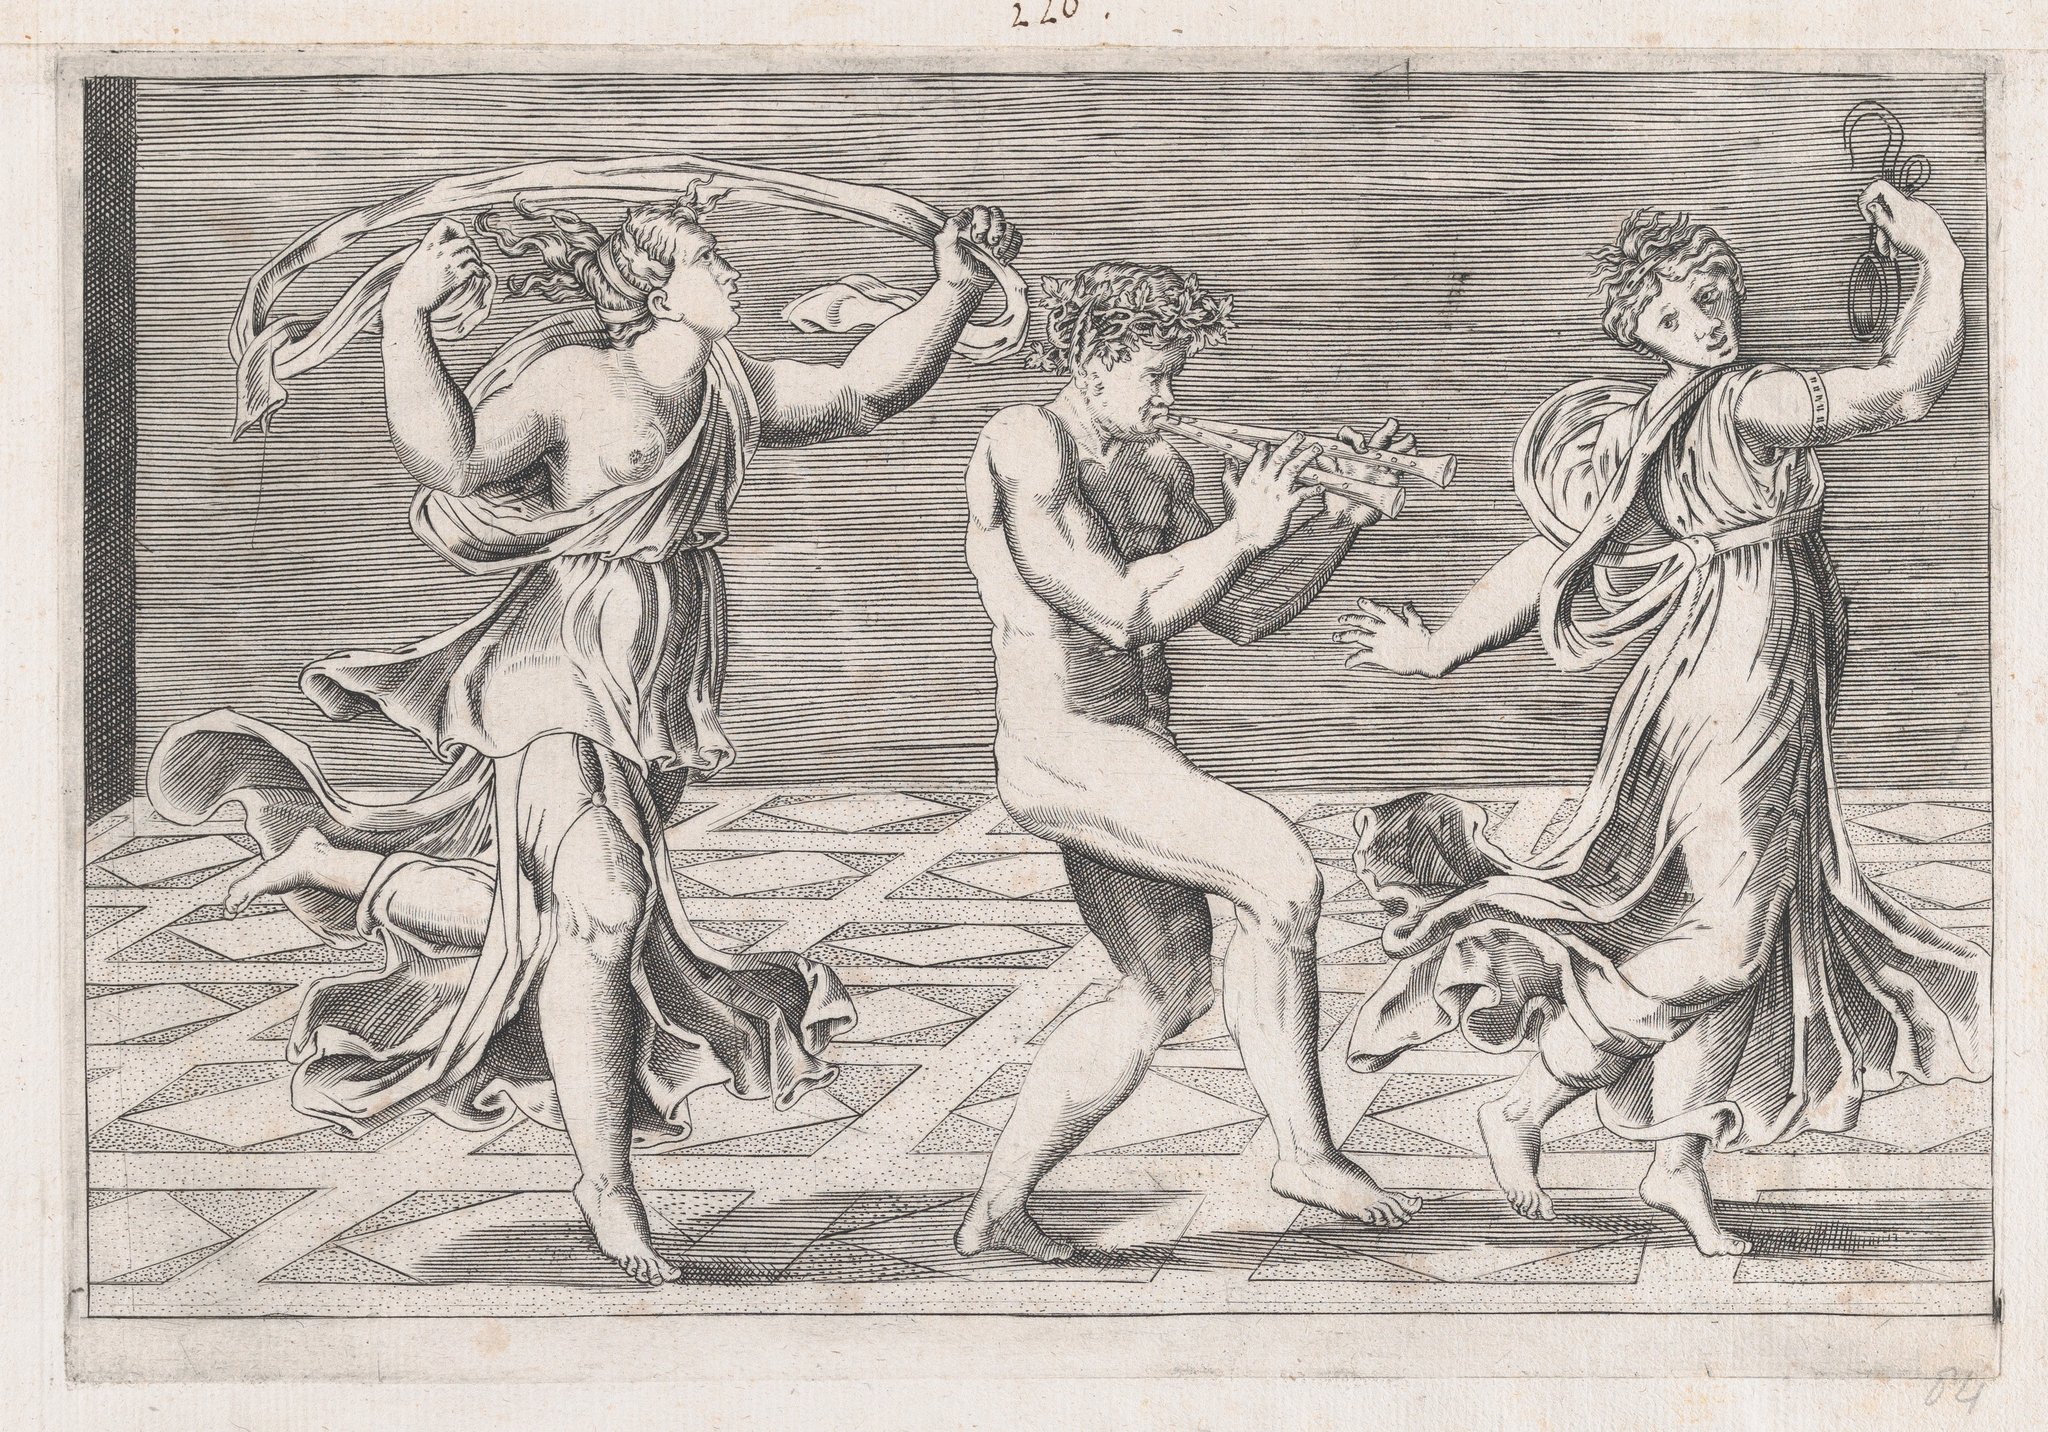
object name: print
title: Dance of Fauns and Bacchants, from "Speculum Romanae Magnificentiae"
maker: Anonymous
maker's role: artist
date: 1501-1533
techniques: engraving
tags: dancing,flutes,bacchantes,fauns